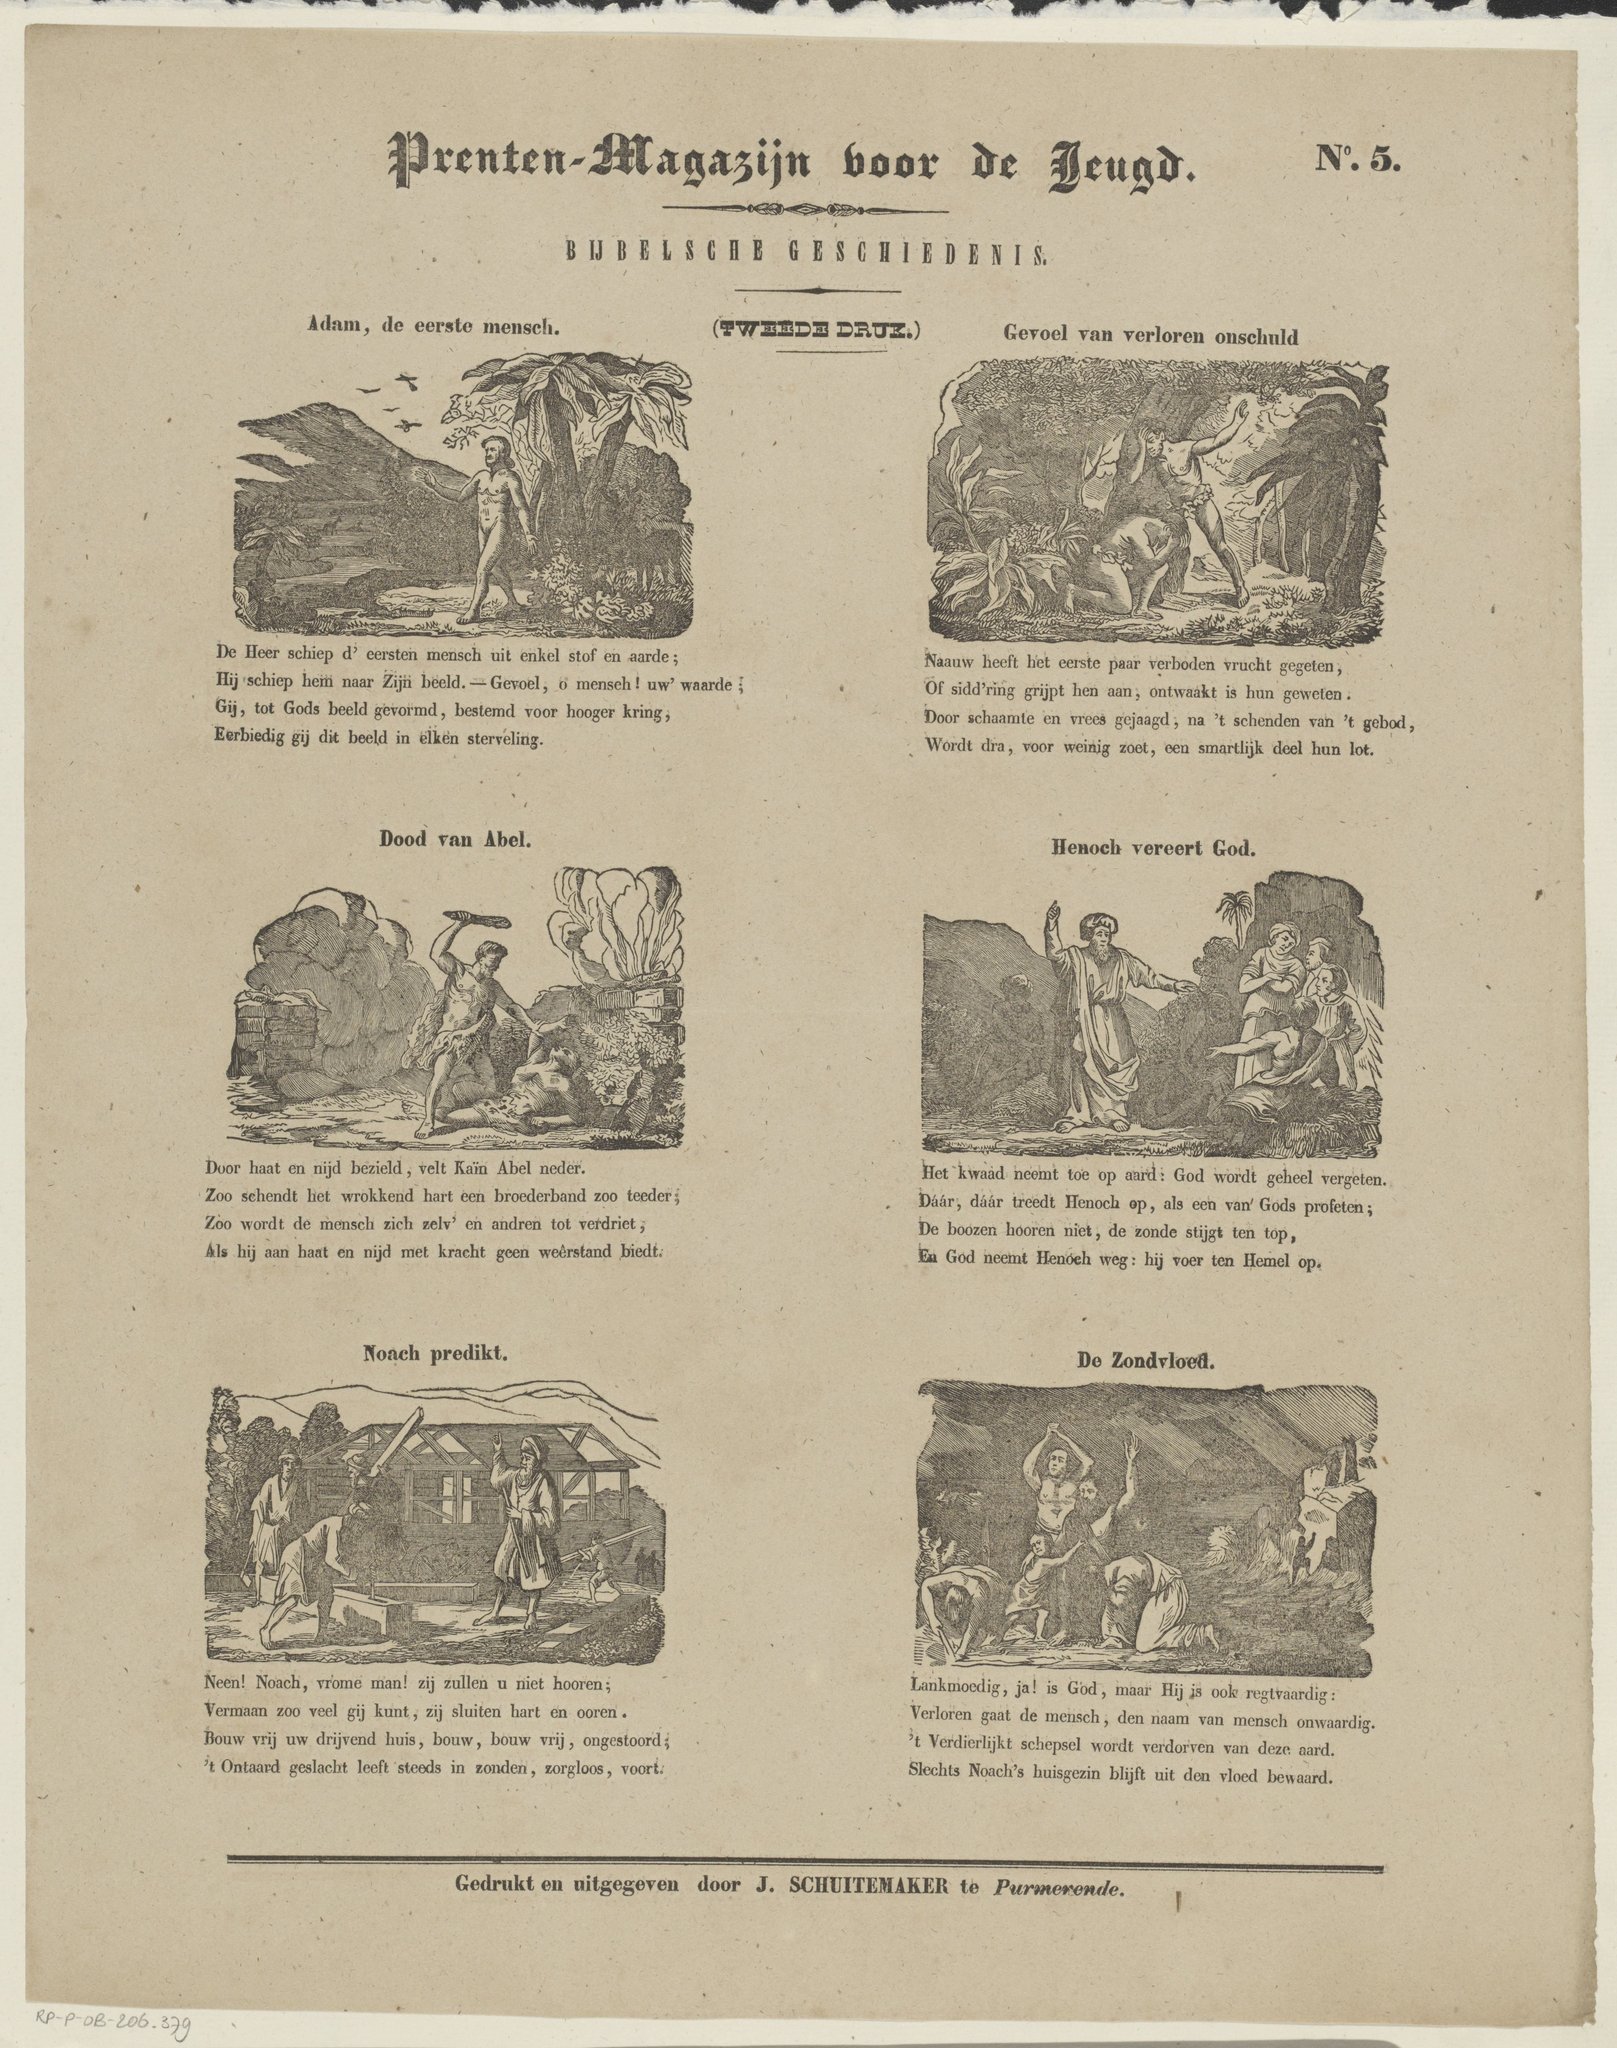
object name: popular print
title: Scènes uit het Oude Testament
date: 1842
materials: paper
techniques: letterpress printing, engraving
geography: purmerend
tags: abel's death, adam as founder, initiator, story of noah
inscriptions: collector's mark: Lugt 2760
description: Blad met 6 voorstellingen van verhalen uit het Oude Testament, zoals de dood van Abel en Noach die predikt. Boven elke voorstelling een titel en onder elke voorstelling een vierregelig vers. Genummerd rechtsboven: No. 5.